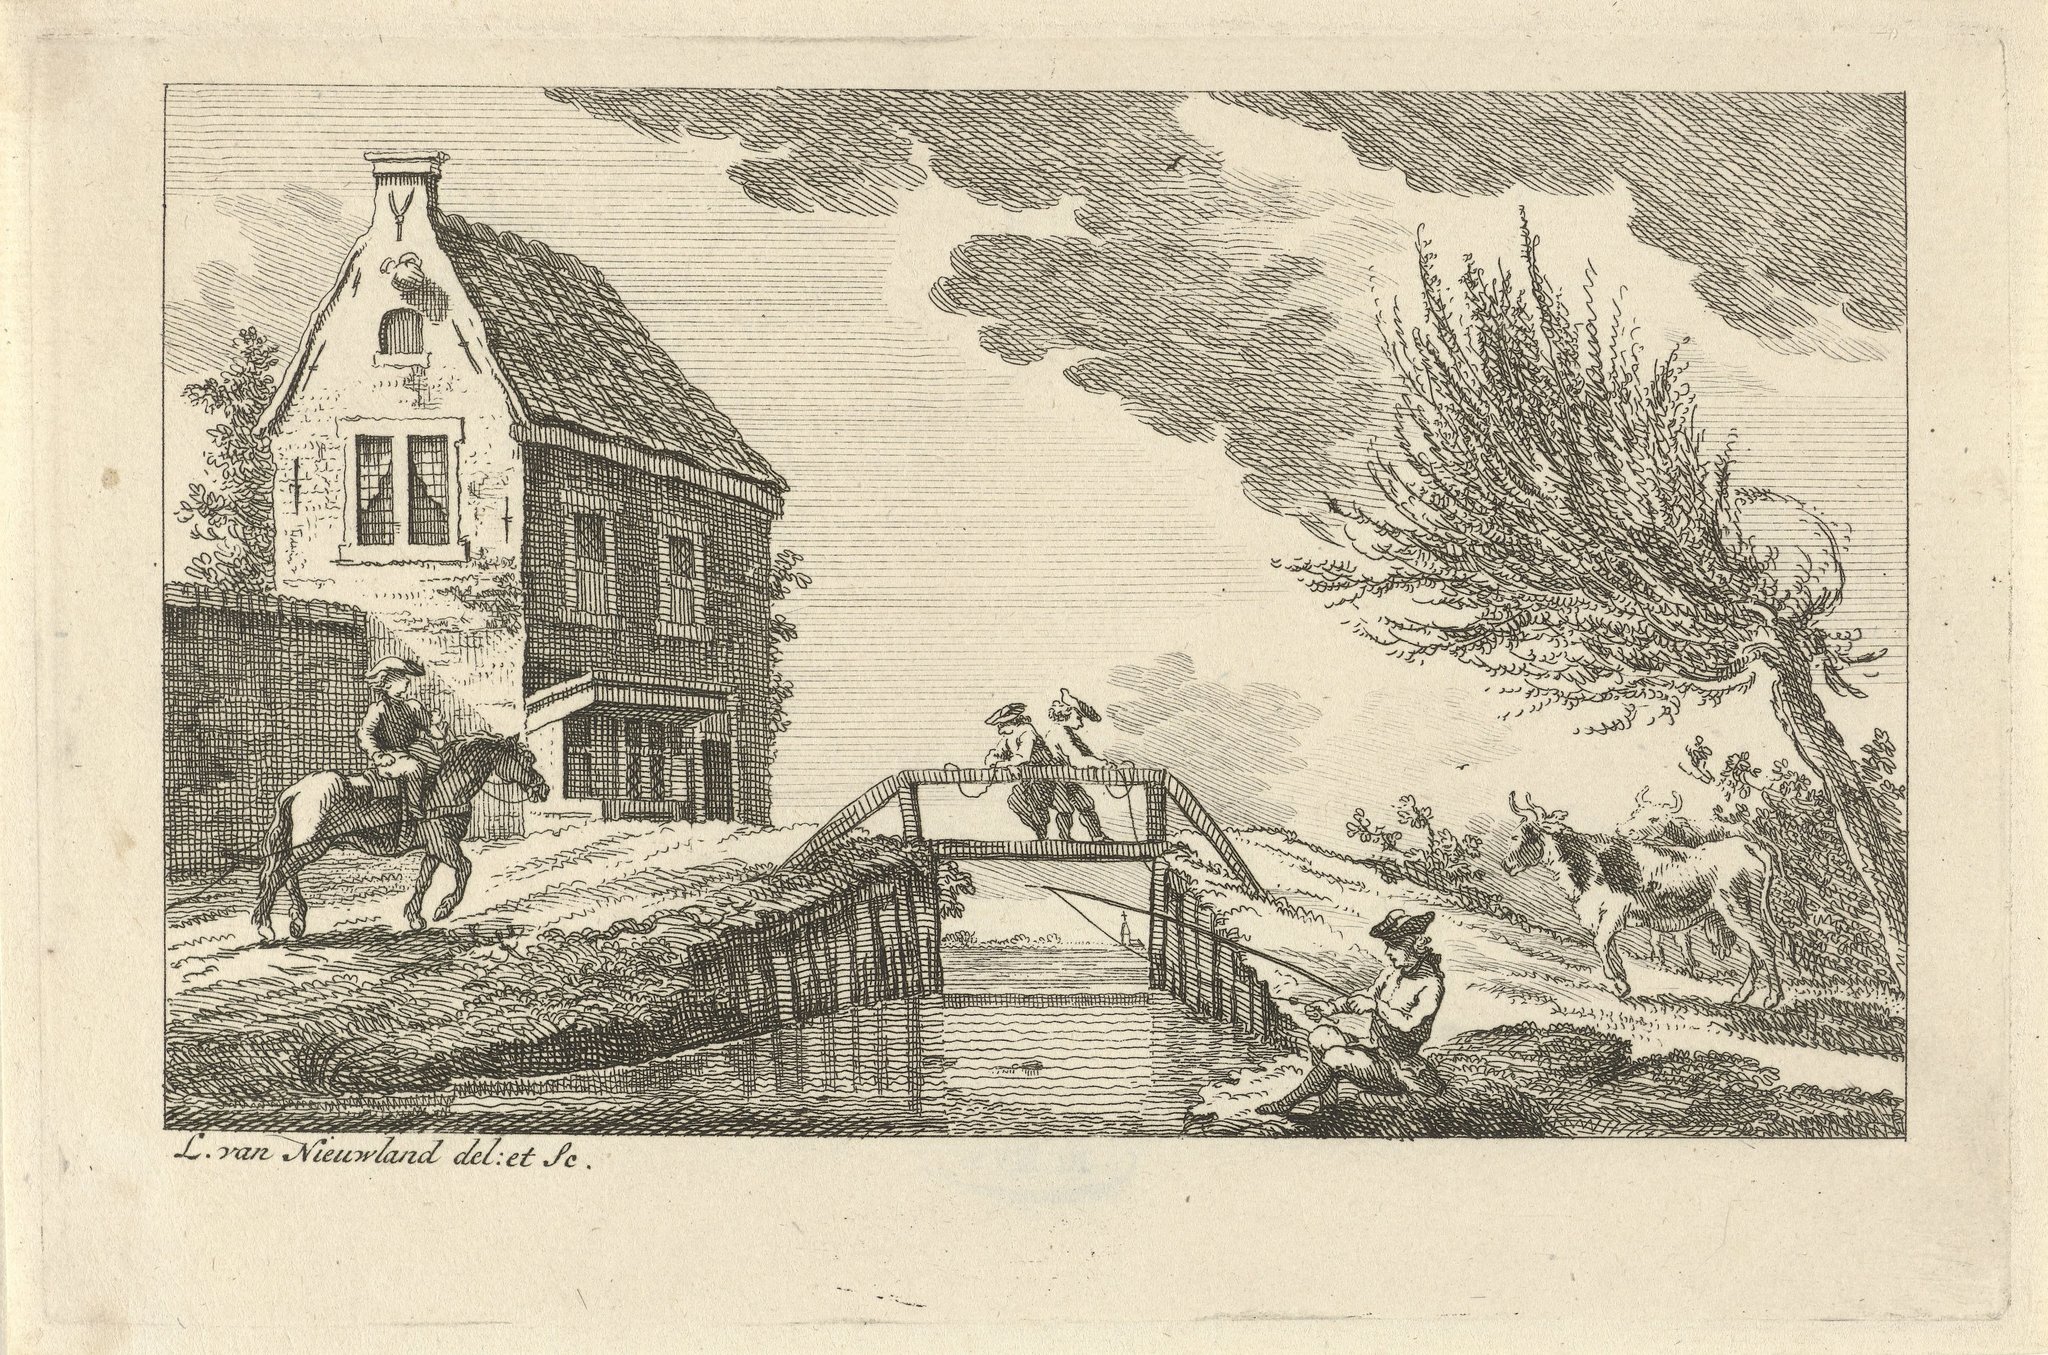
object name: print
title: Gezicht op een vaart met brug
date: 1763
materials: paper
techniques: etching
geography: amsterdam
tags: landscape with bridge, viaduct or aqueduct, fisherman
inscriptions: collector's mark: Lugt 2228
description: Gezicht op een vaart met brug waarop twee figuren staan. Links een ruiter bij een huis, aan de overkant van het water een vissende figuur en twee stieren.